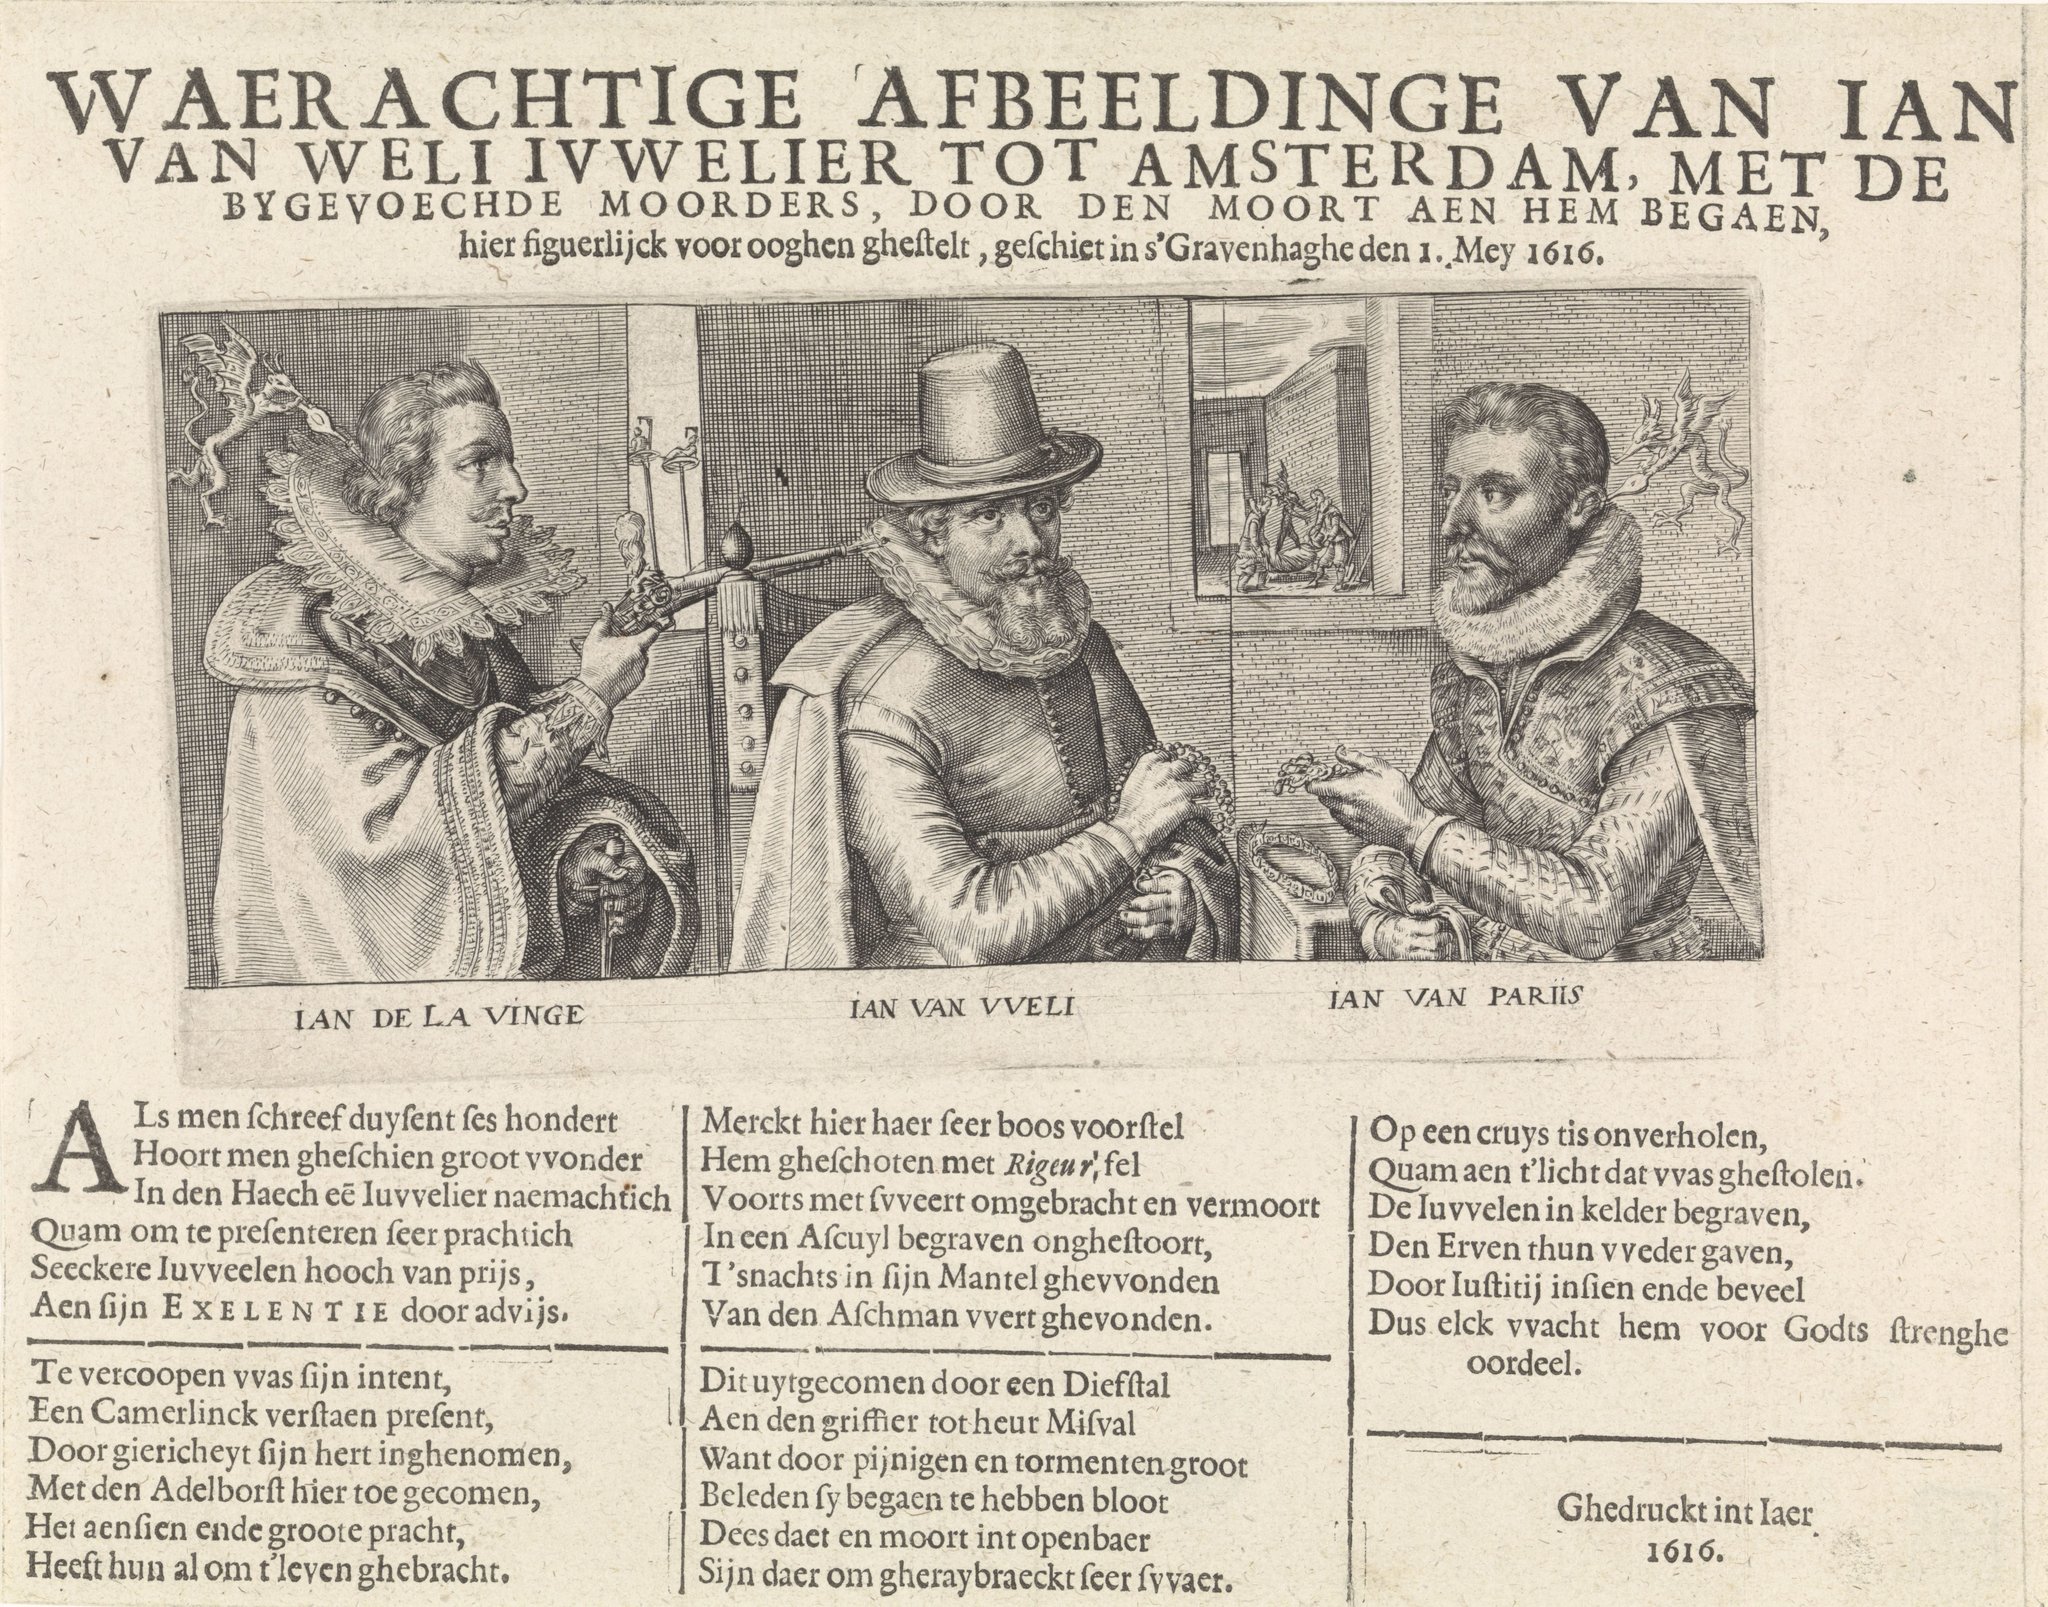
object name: print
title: Waerachtige afbeeldinge van Ian van Weli ivwelier tot Amsterdam (...)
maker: crispijn van de passe (i)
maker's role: draughtsman, print maker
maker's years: 1564-1637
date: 1616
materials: paper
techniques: engraving, letterpress printing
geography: utrecht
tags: the hague, violent death by breaking on the wheel, neck-gear ~ clothing (with name) (+ men's clothes), cape (+ men's clothes), historical persons, head-gear: hat (+ men's clothes), jeweller, goldsmith, silversmith, violent death, being killed; being mishandled and maltreated; seeking death, clothing for the upper part of the body (doublet) (+ men's clothes), murderer, netherlands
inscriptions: collector's mark: Lugt 2228, collector's mark: Lugt 963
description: Portret van Jan van Weli, in het midden, met geplooide kraag en hoge hoed op het hoofd. Rechts Jan van Parijs, met dubbele fijn geplooide kraag; links Ian de la Vigne, met wijduitstaande kanten kraag.